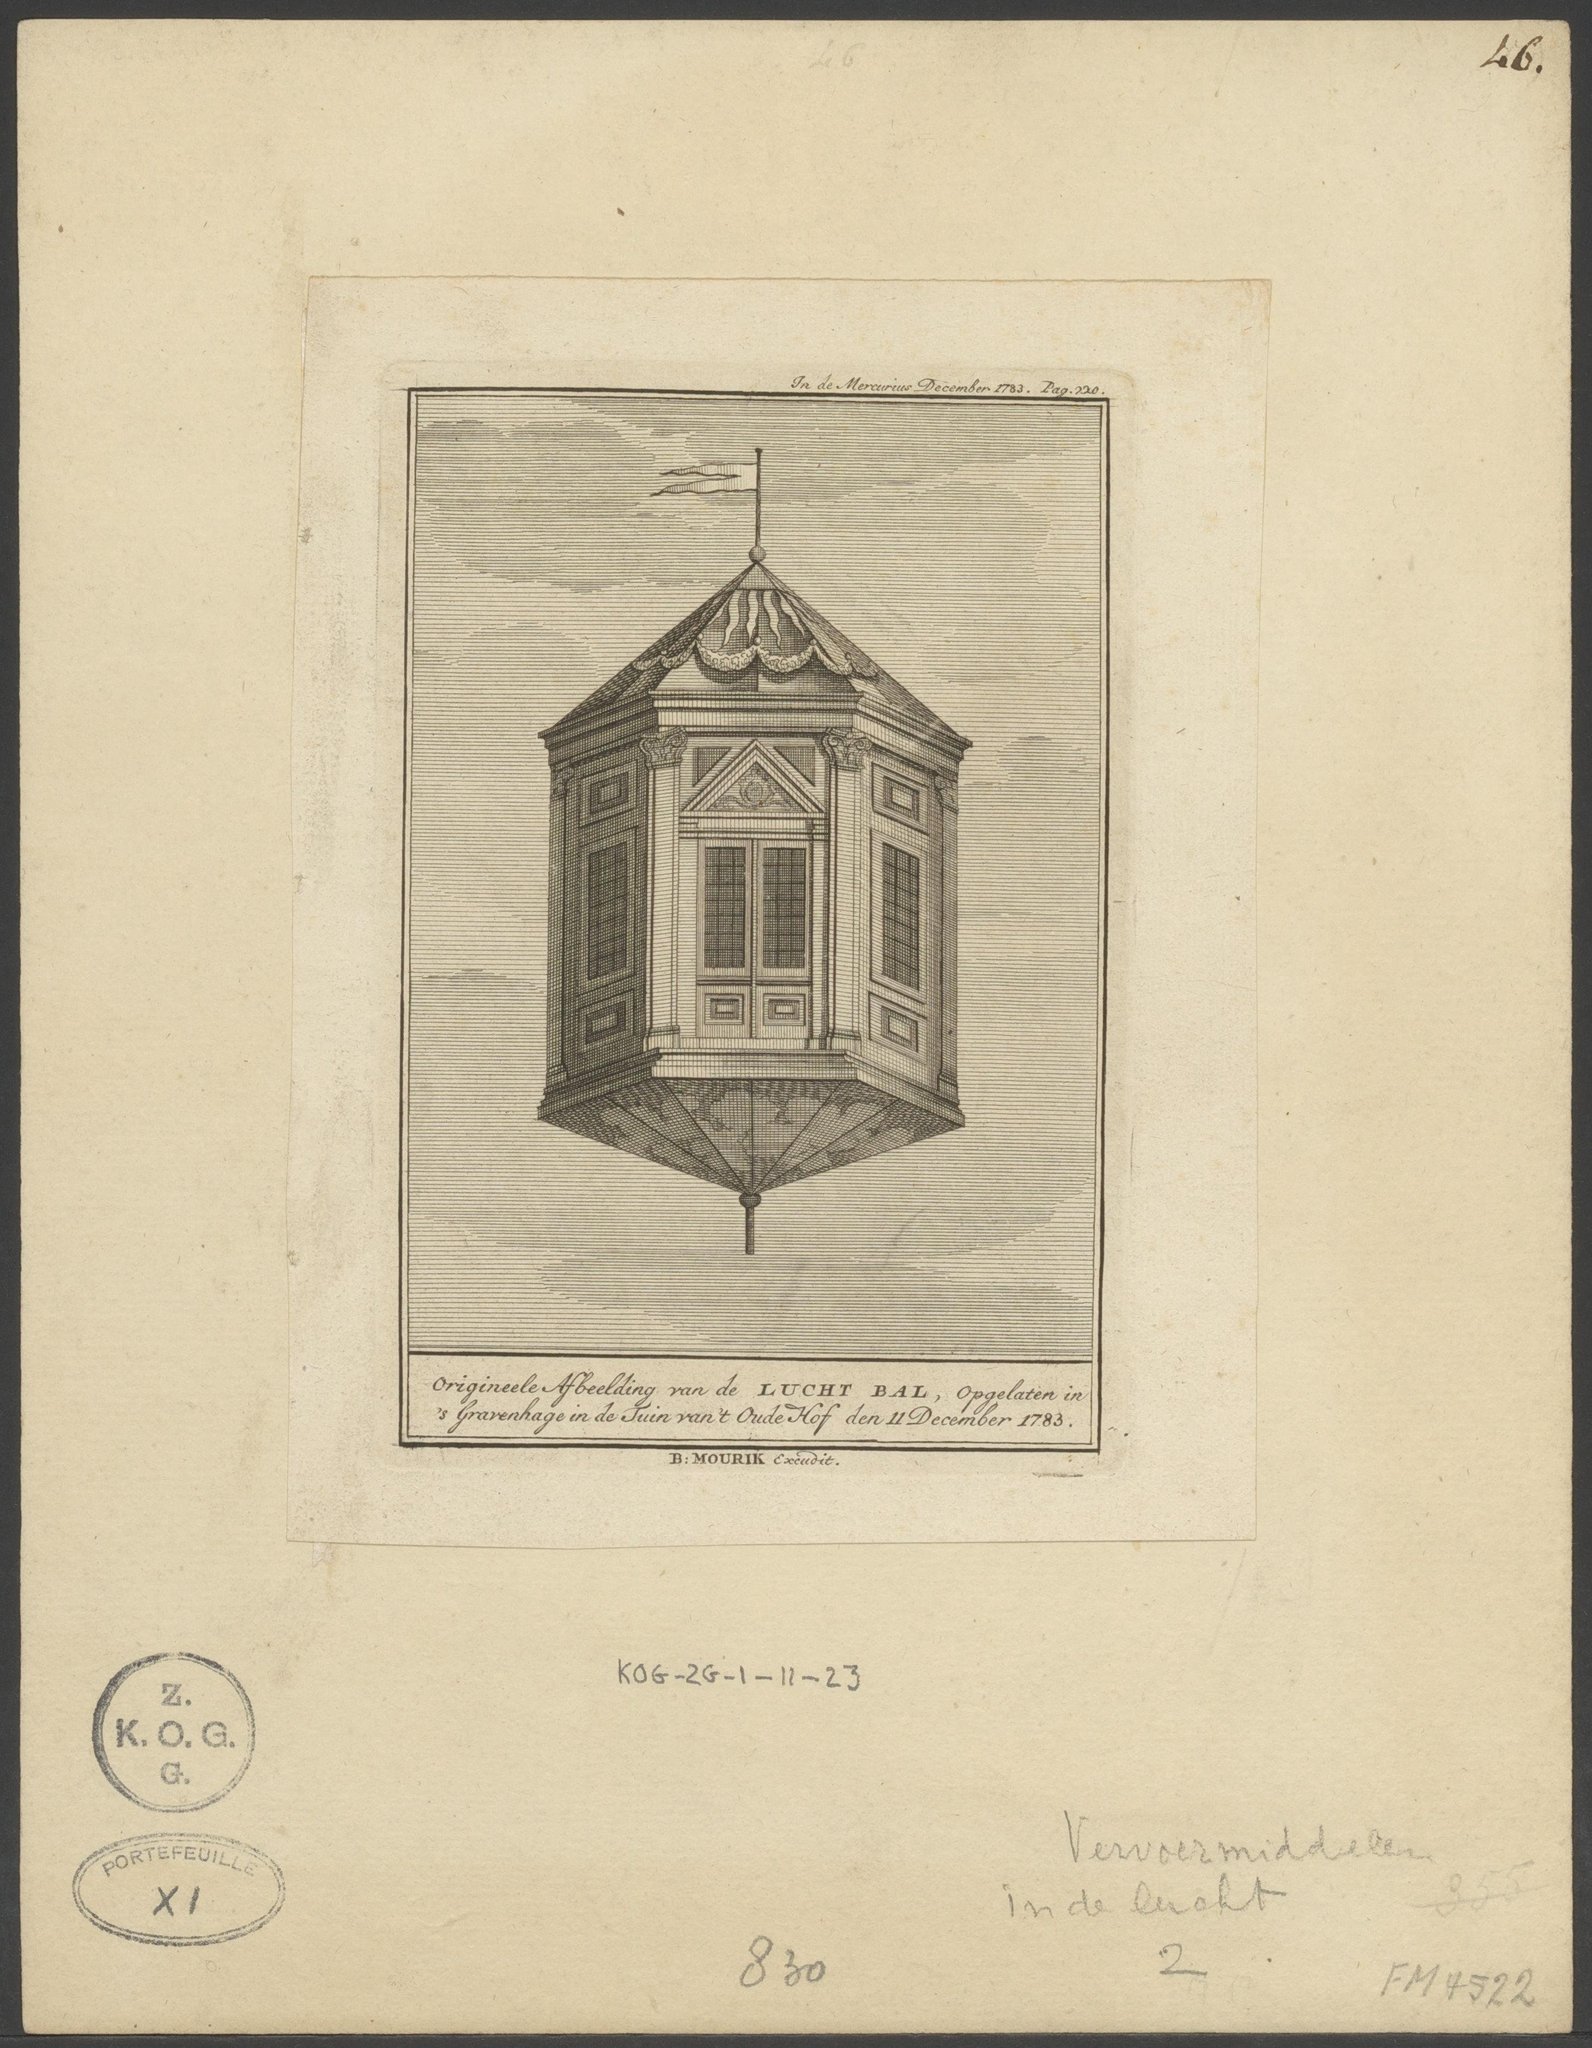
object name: print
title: Origineele Afbeelding van de Lucht Bal, opgelaten in 's Gravenhage in de Tuin van 't Oude Hof den 11 december 1783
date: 1712-1783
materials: paper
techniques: engraving, etching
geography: amsterdam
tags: balloon (aviation), the hague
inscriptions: stamp, collector's mark: Lugt 1641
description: Luchtballon in de vorm van een huis, opgelaten te Den Haag op 11 december 1783. Rechtsboven genummerd: In de Mercurius December 1783. Pag. 220. Onderwerpsrubrieken binnen de Atlas Zeden en Gewoonten: Handel, nijverheid en verkeer, Vervoermiddelen te land en te water, Vervoermiddelen in de lucht.